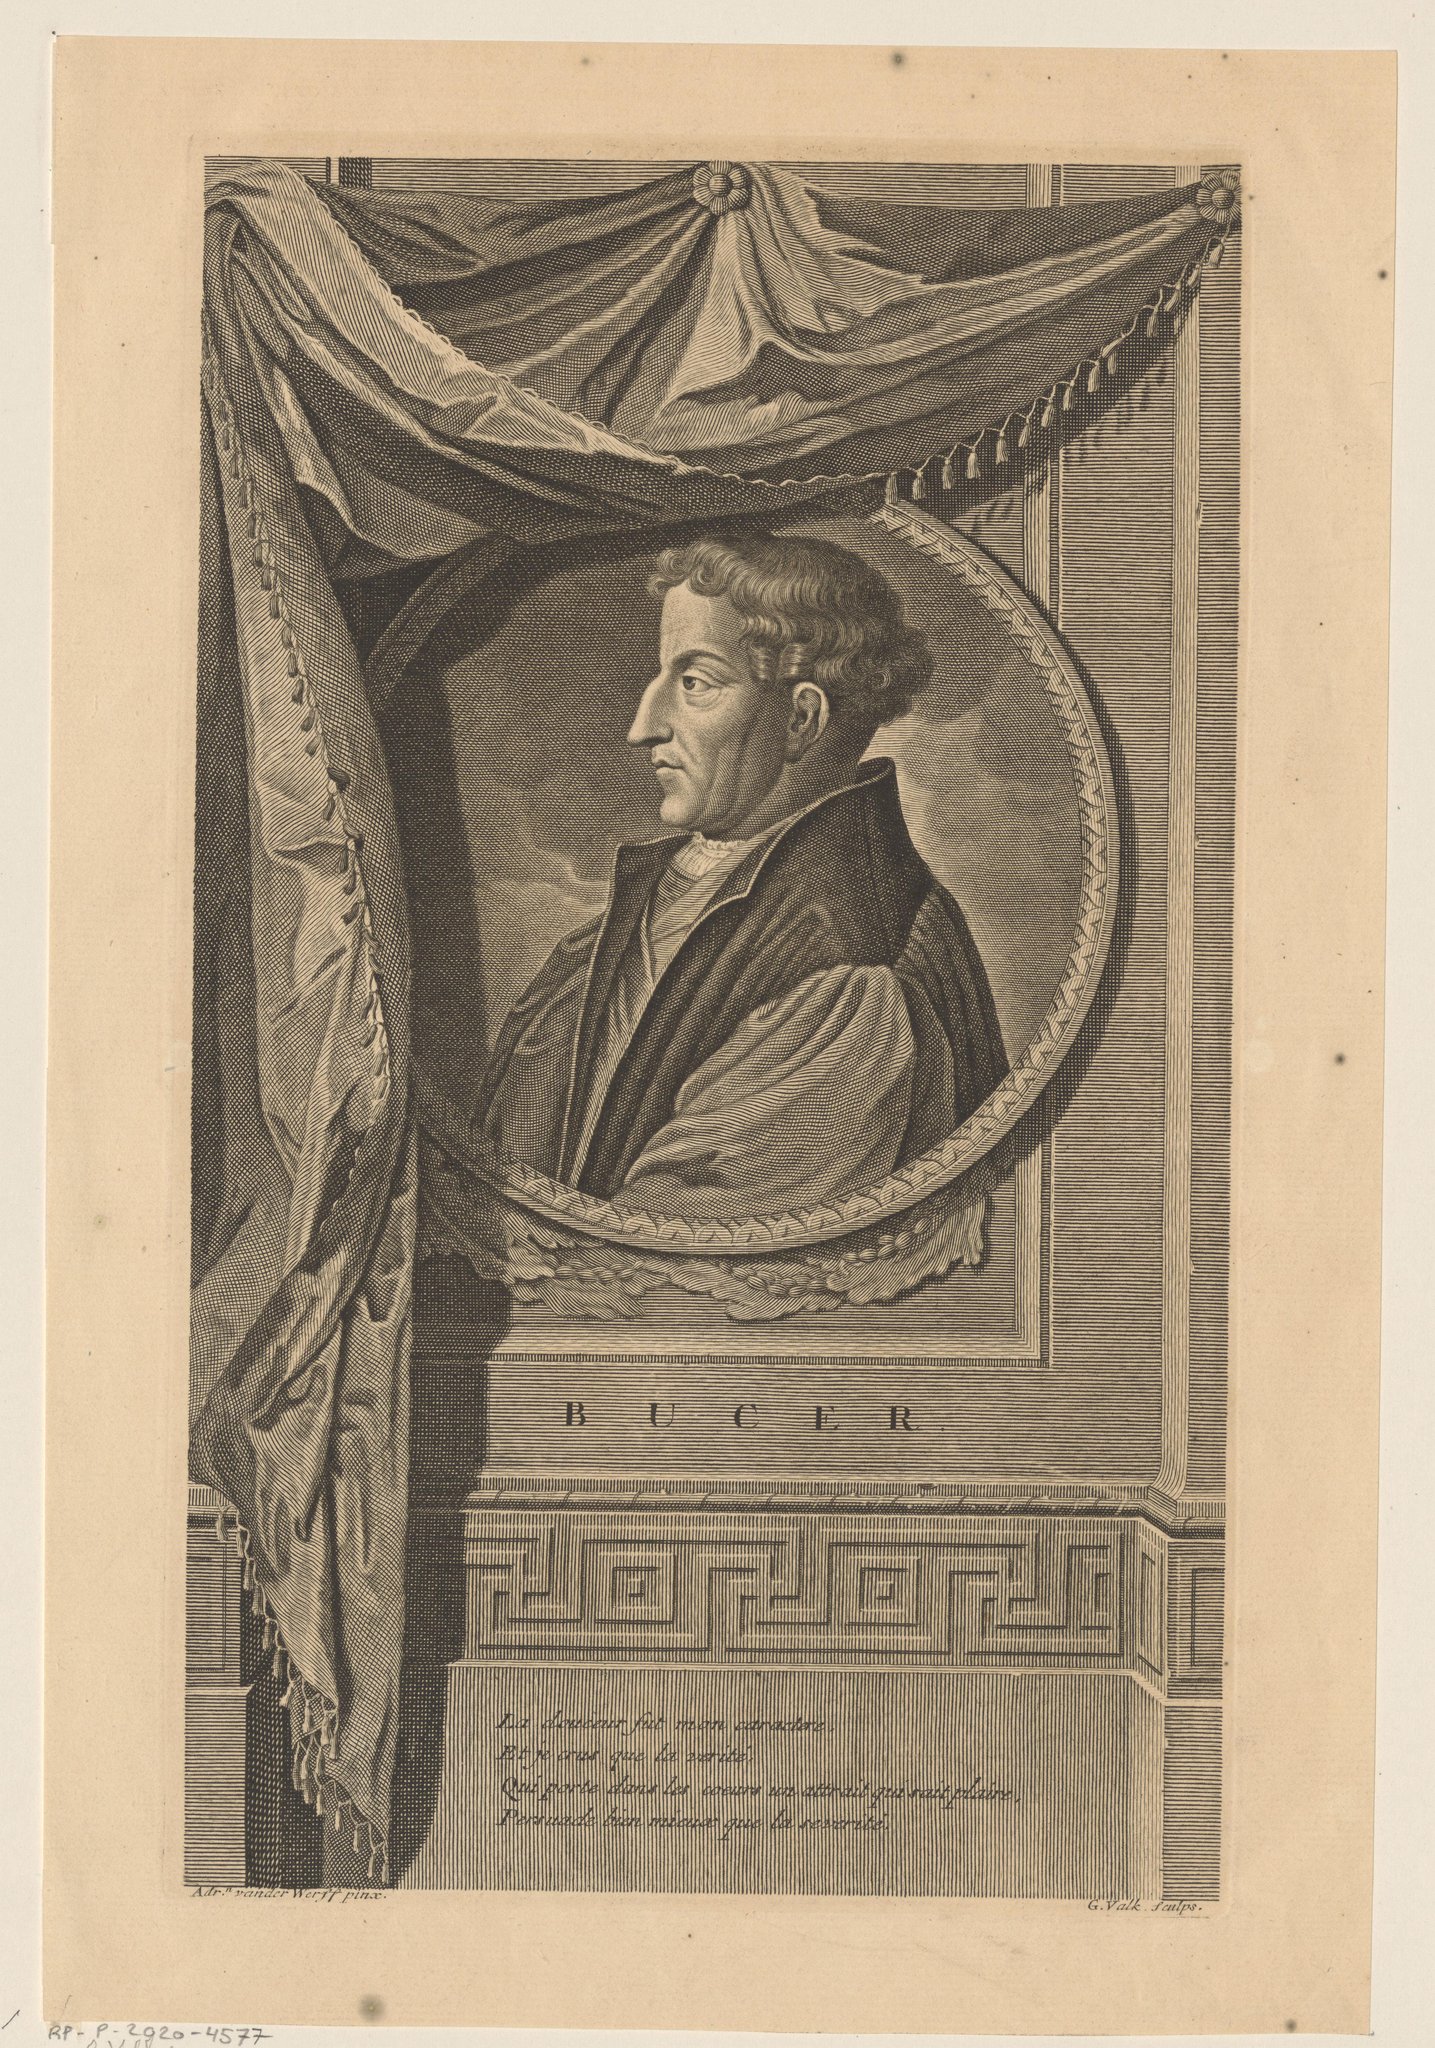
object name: print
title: Portret van Martin Bucer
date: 1670-1726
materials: paper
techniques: engraving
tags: theologian, historical persons